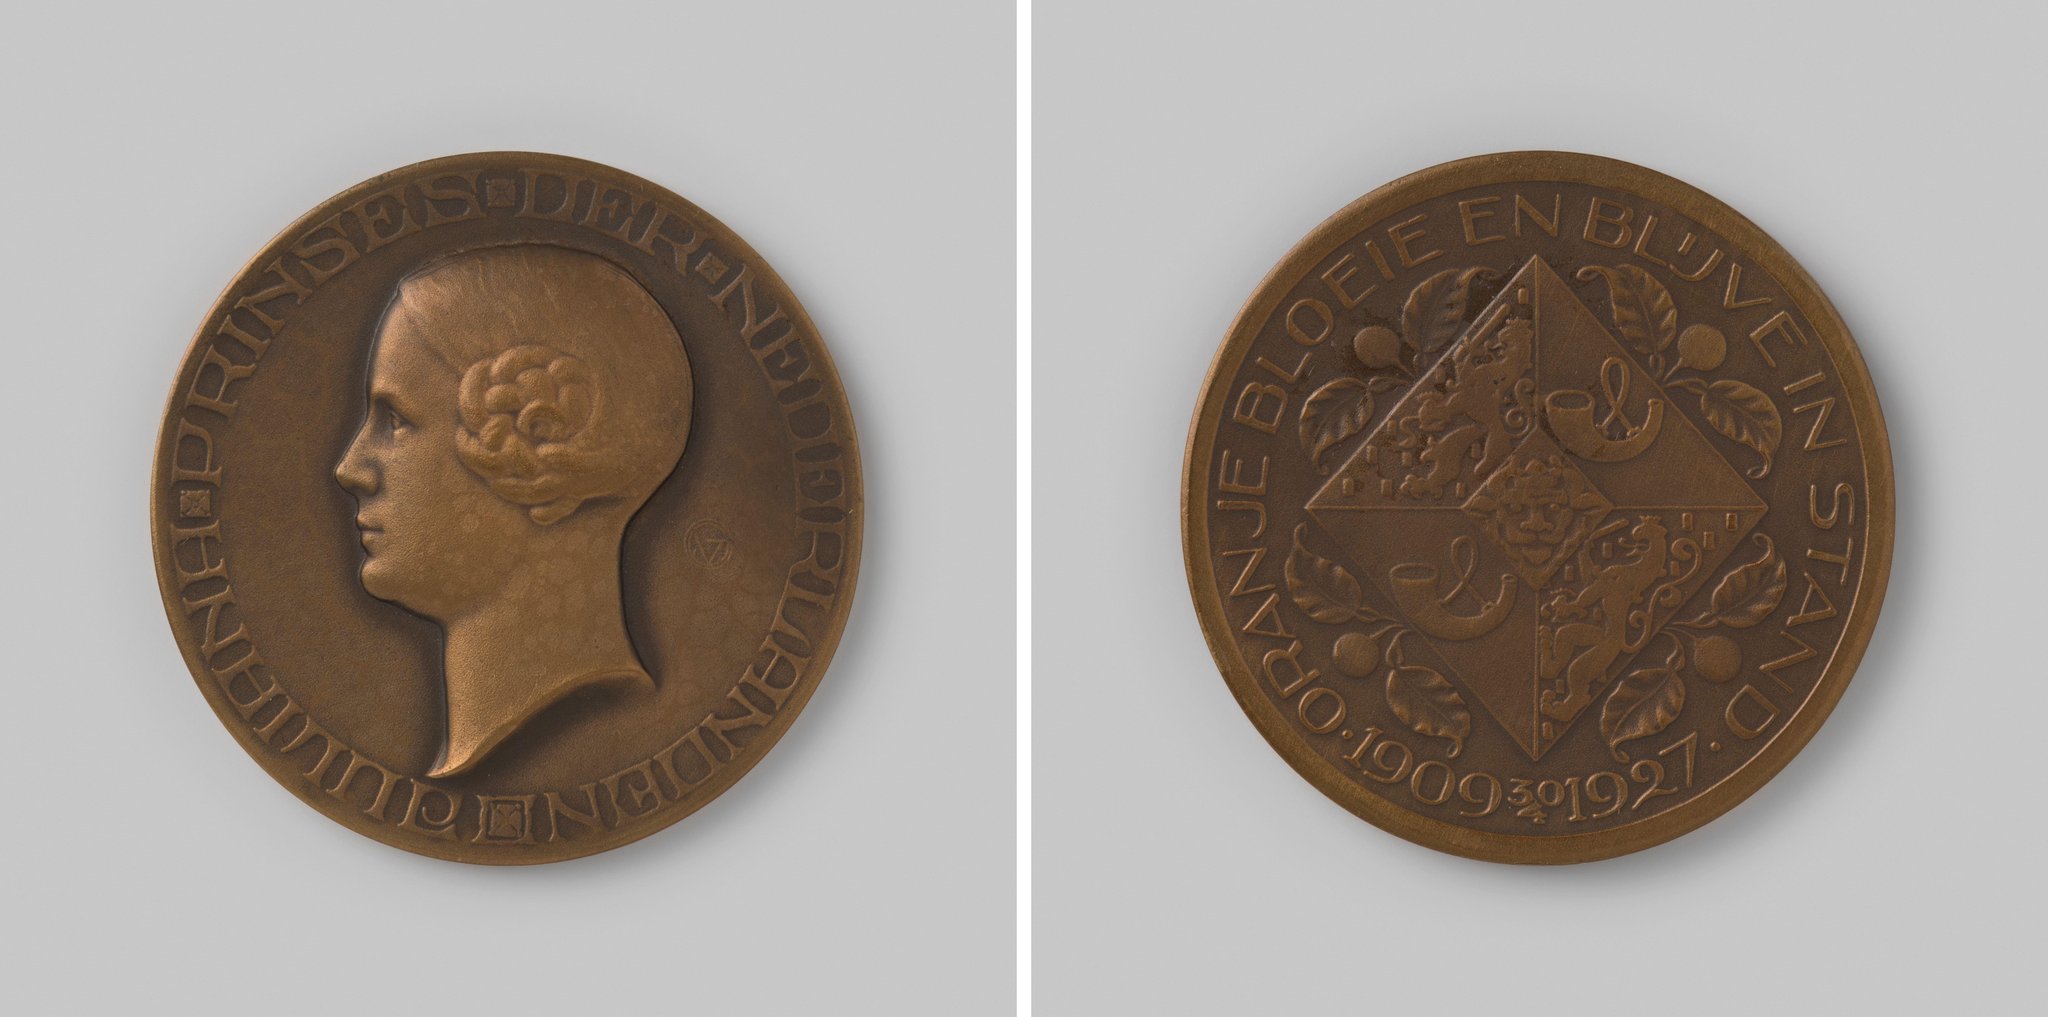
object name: history medal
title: Achttiende verjaardag van Prinses Juliana 1927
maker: jacob jan van goor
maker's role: medailleur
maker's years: 1874-1956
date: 1927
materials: bronze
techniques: striking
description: Bronzen penning, op de voorzijde het portret van Juliana naar links met omschrift, op de keerzijde het ruitvormige wapenschild van Juliana te midden van oranjetakken, met omschrift.